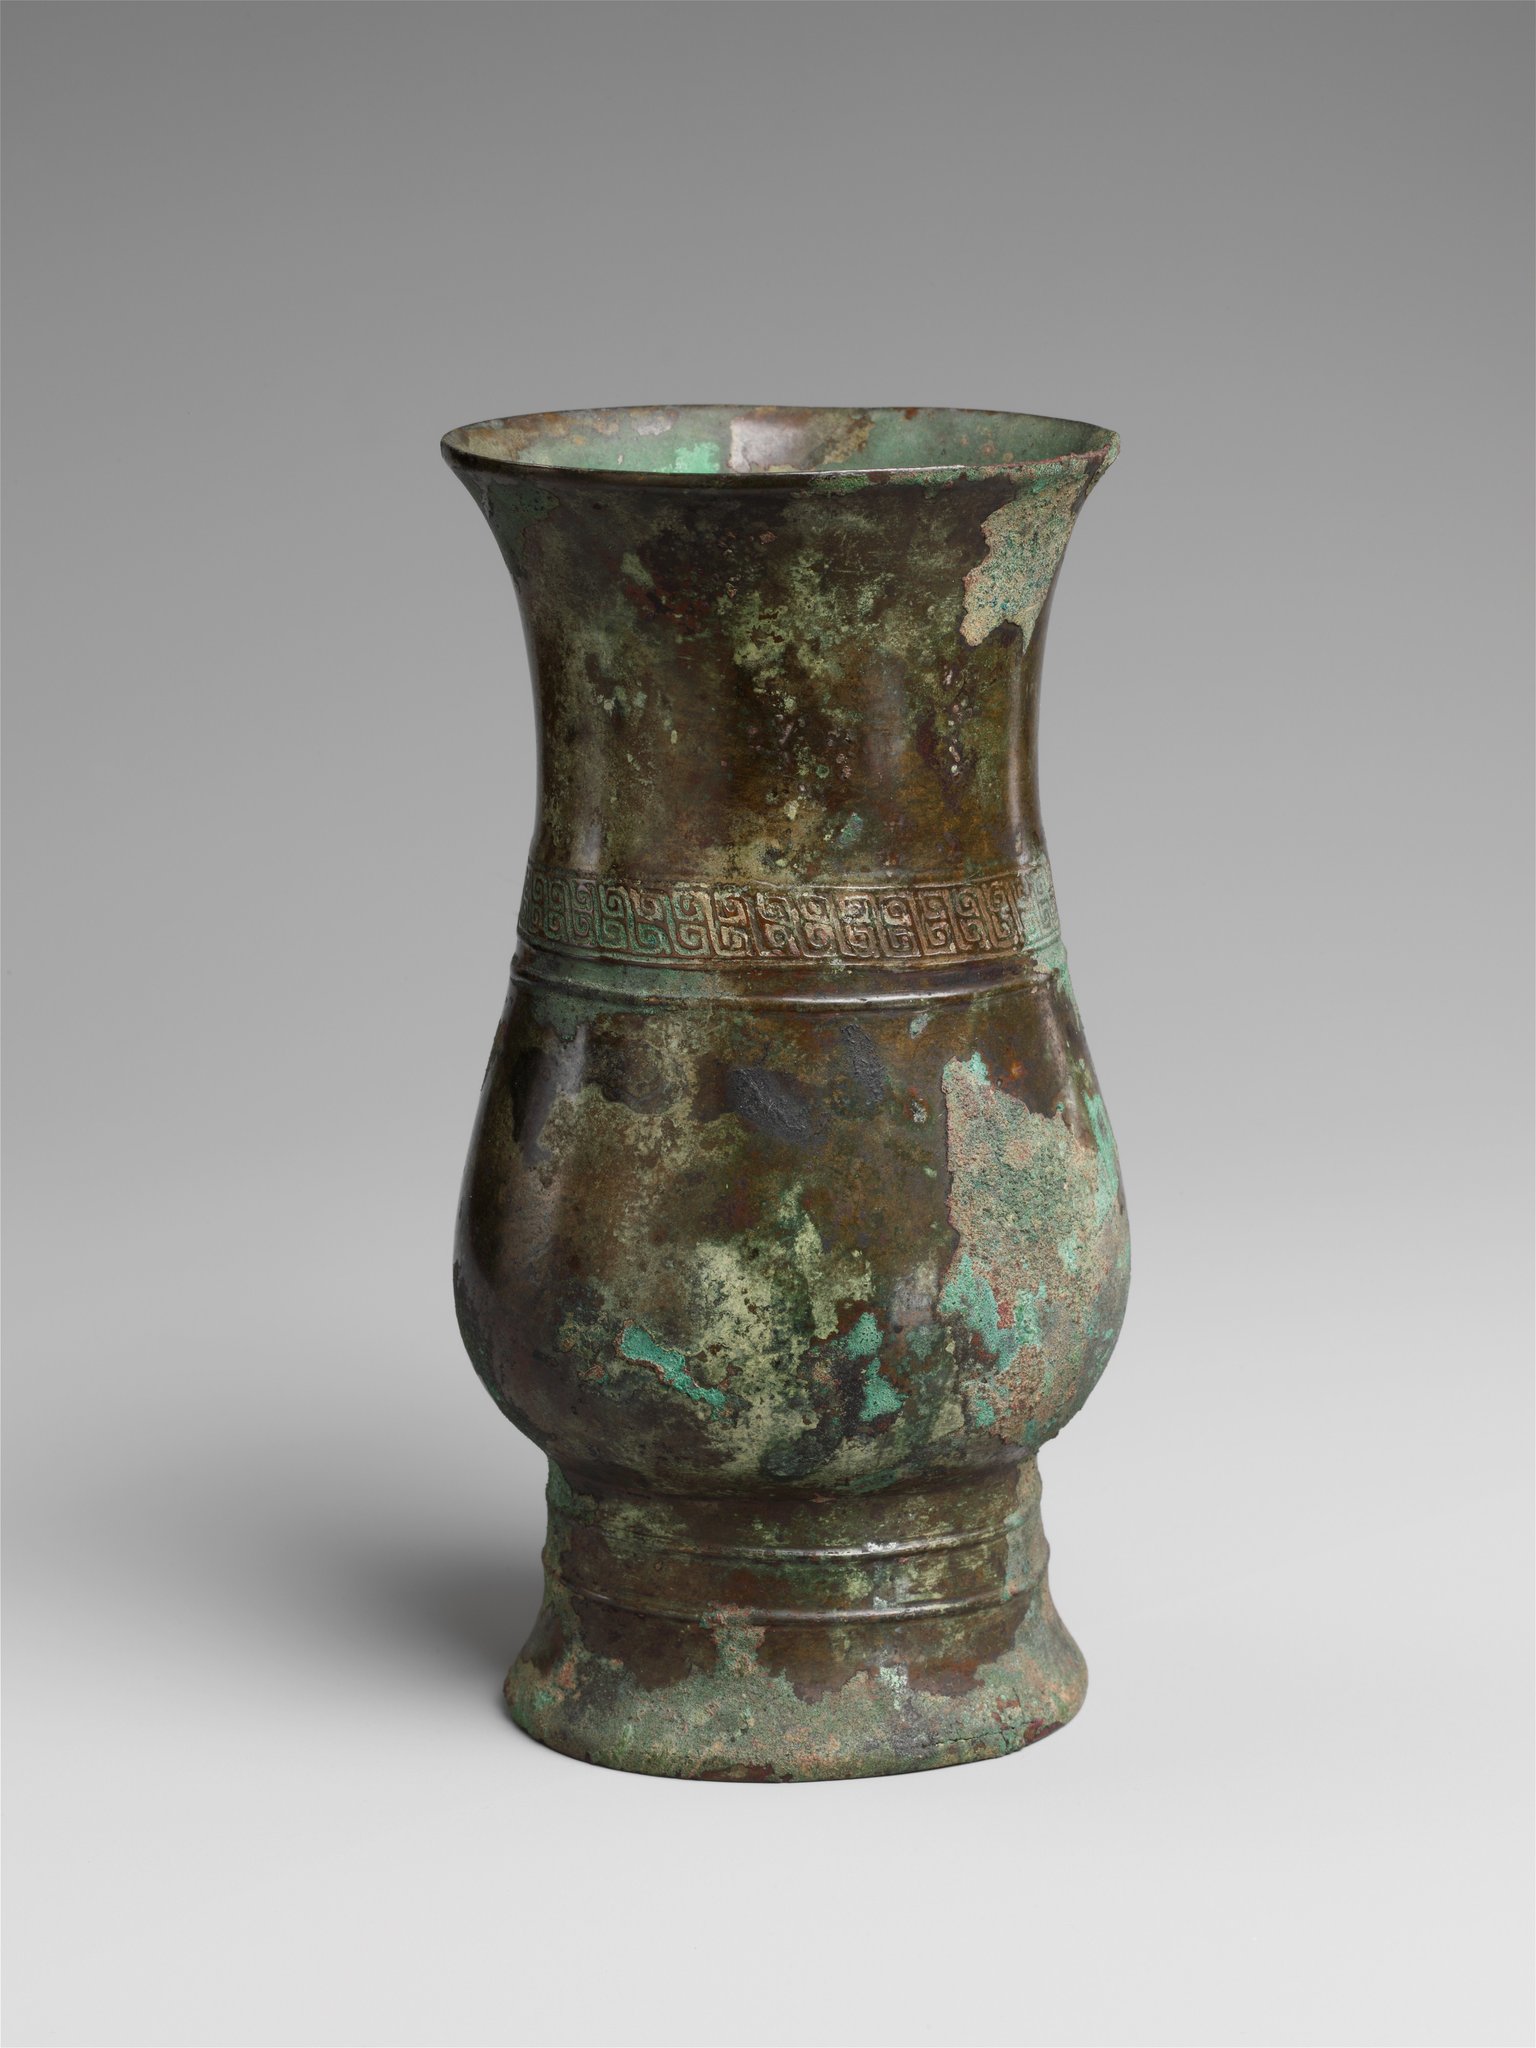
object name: wine cup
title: Wine Cup (Zhi)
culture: chinese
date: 1100-1001 BCE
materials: bronze